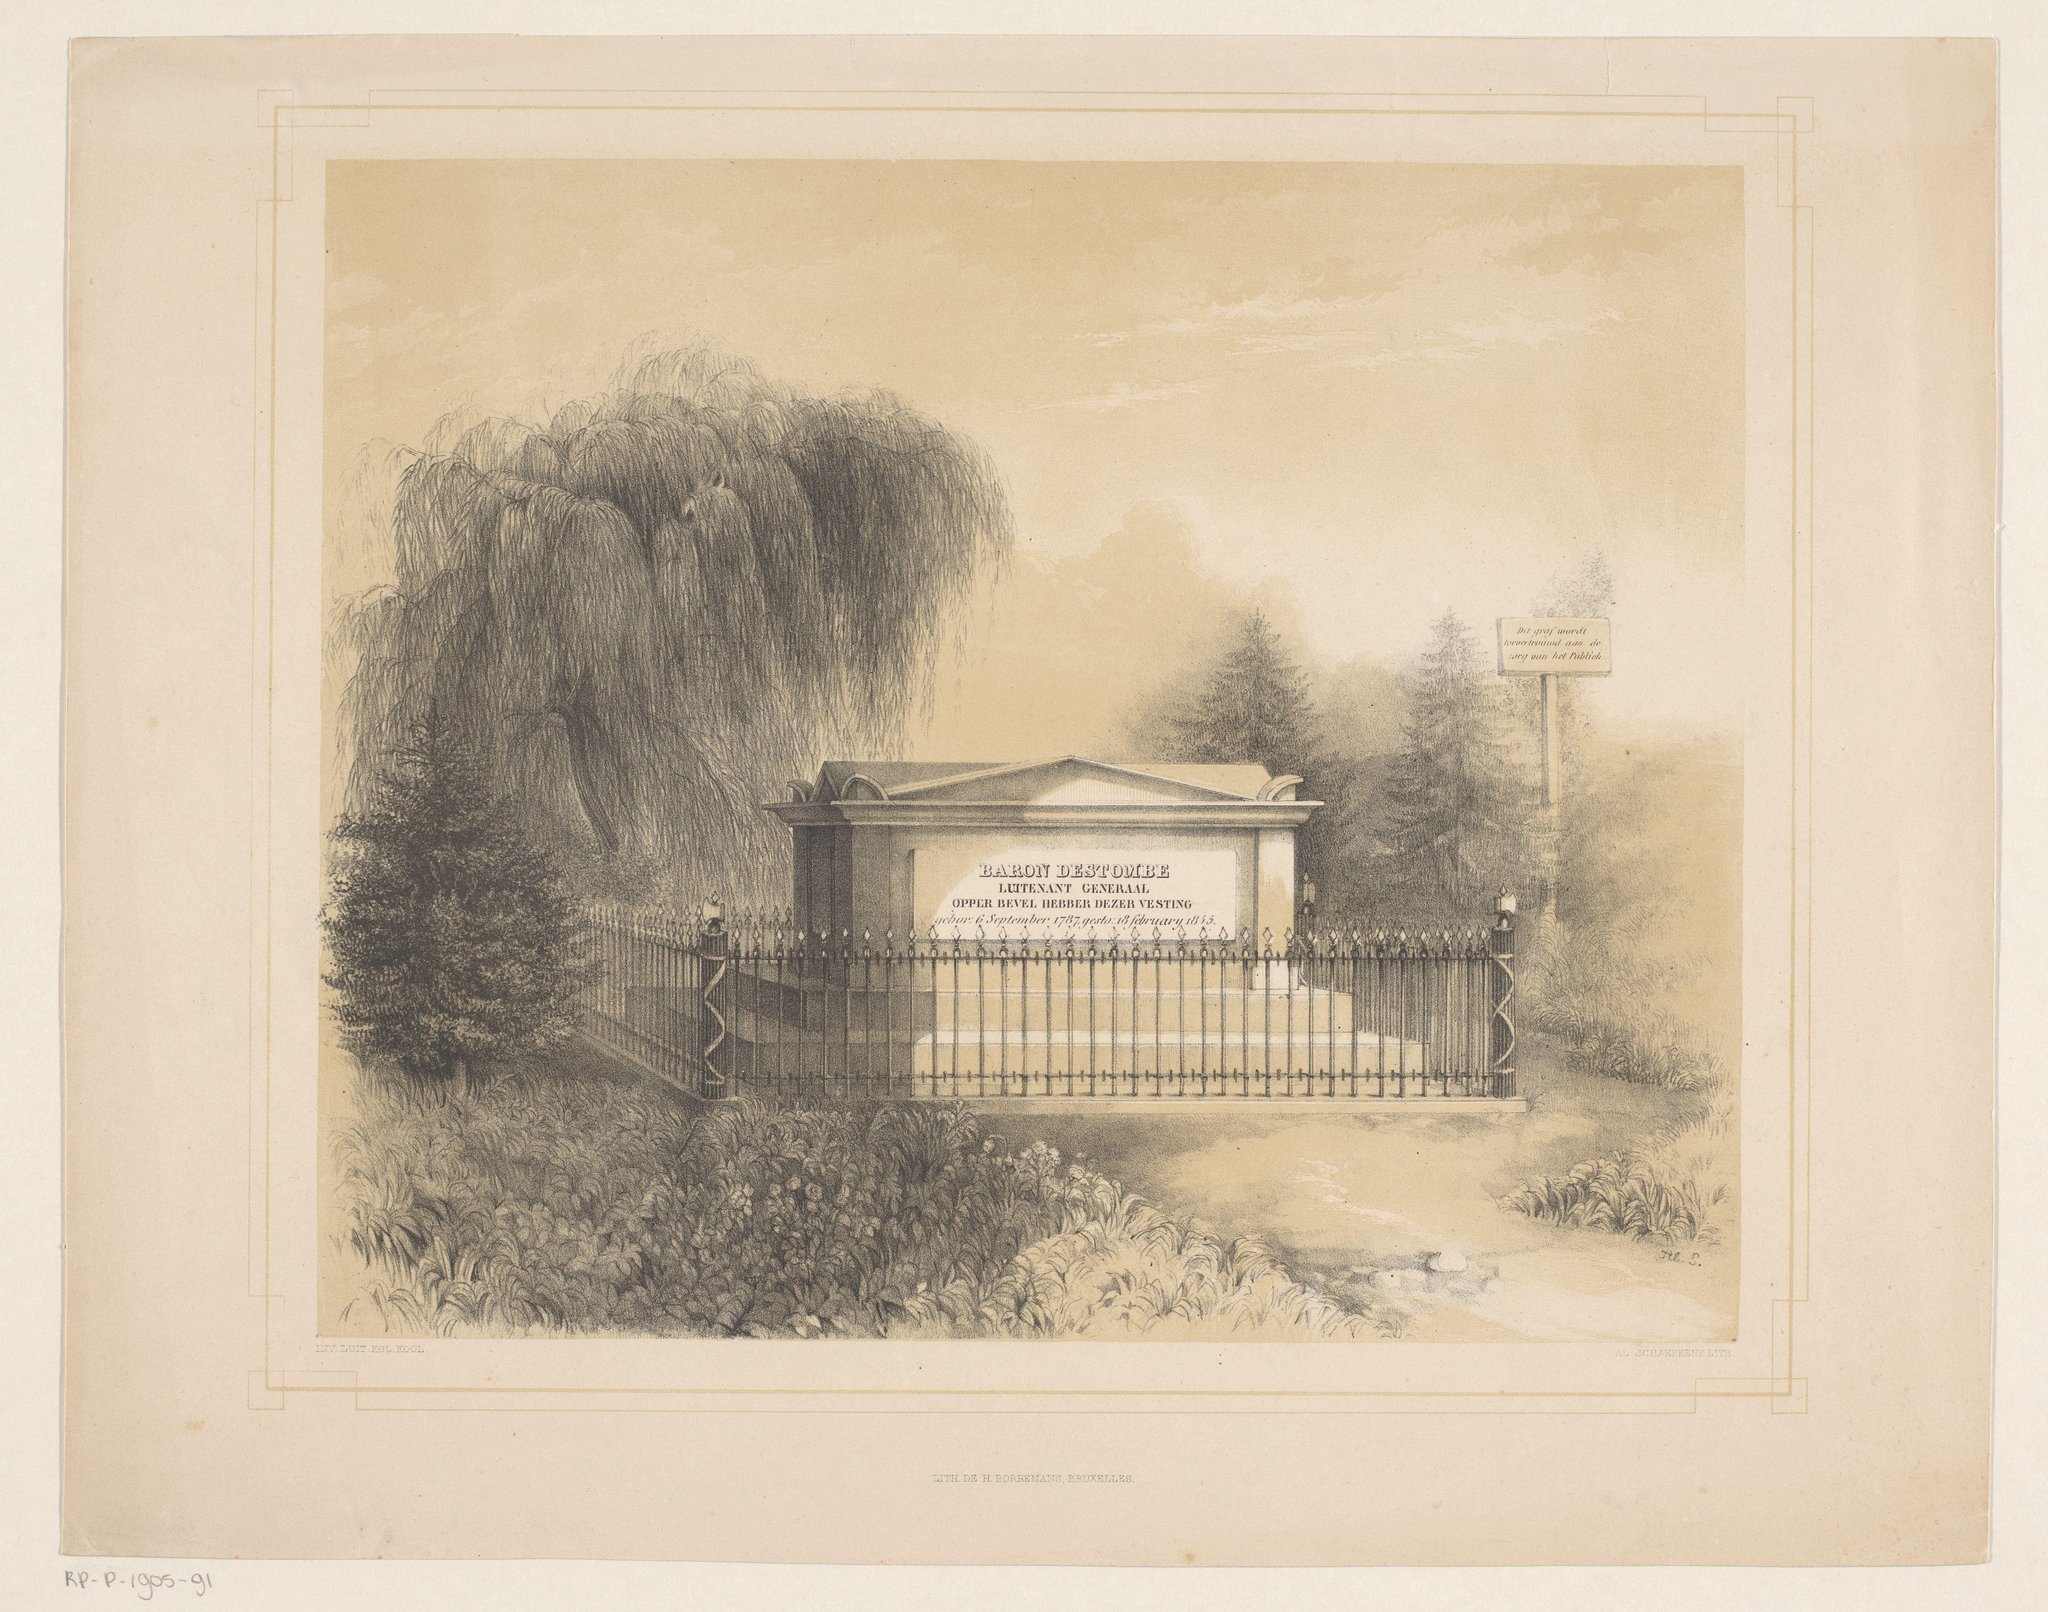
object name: print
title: Graftombe van Andries Jan Jacob baron des Tombe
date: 1845-1899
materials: paper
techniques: tone lithography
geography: brussels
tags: grave, tomb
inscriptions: collector's mark: Lugt 2228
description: Graftombe van baron des Tombe in het park rondom bastion Waldeck te Maastricht. Oorspronkelijk bevond de tombe zich bij de Boschpoort op het Biezenbastion. In 1926 werd get verplaatst in verband met sloop van de vestingwerken.